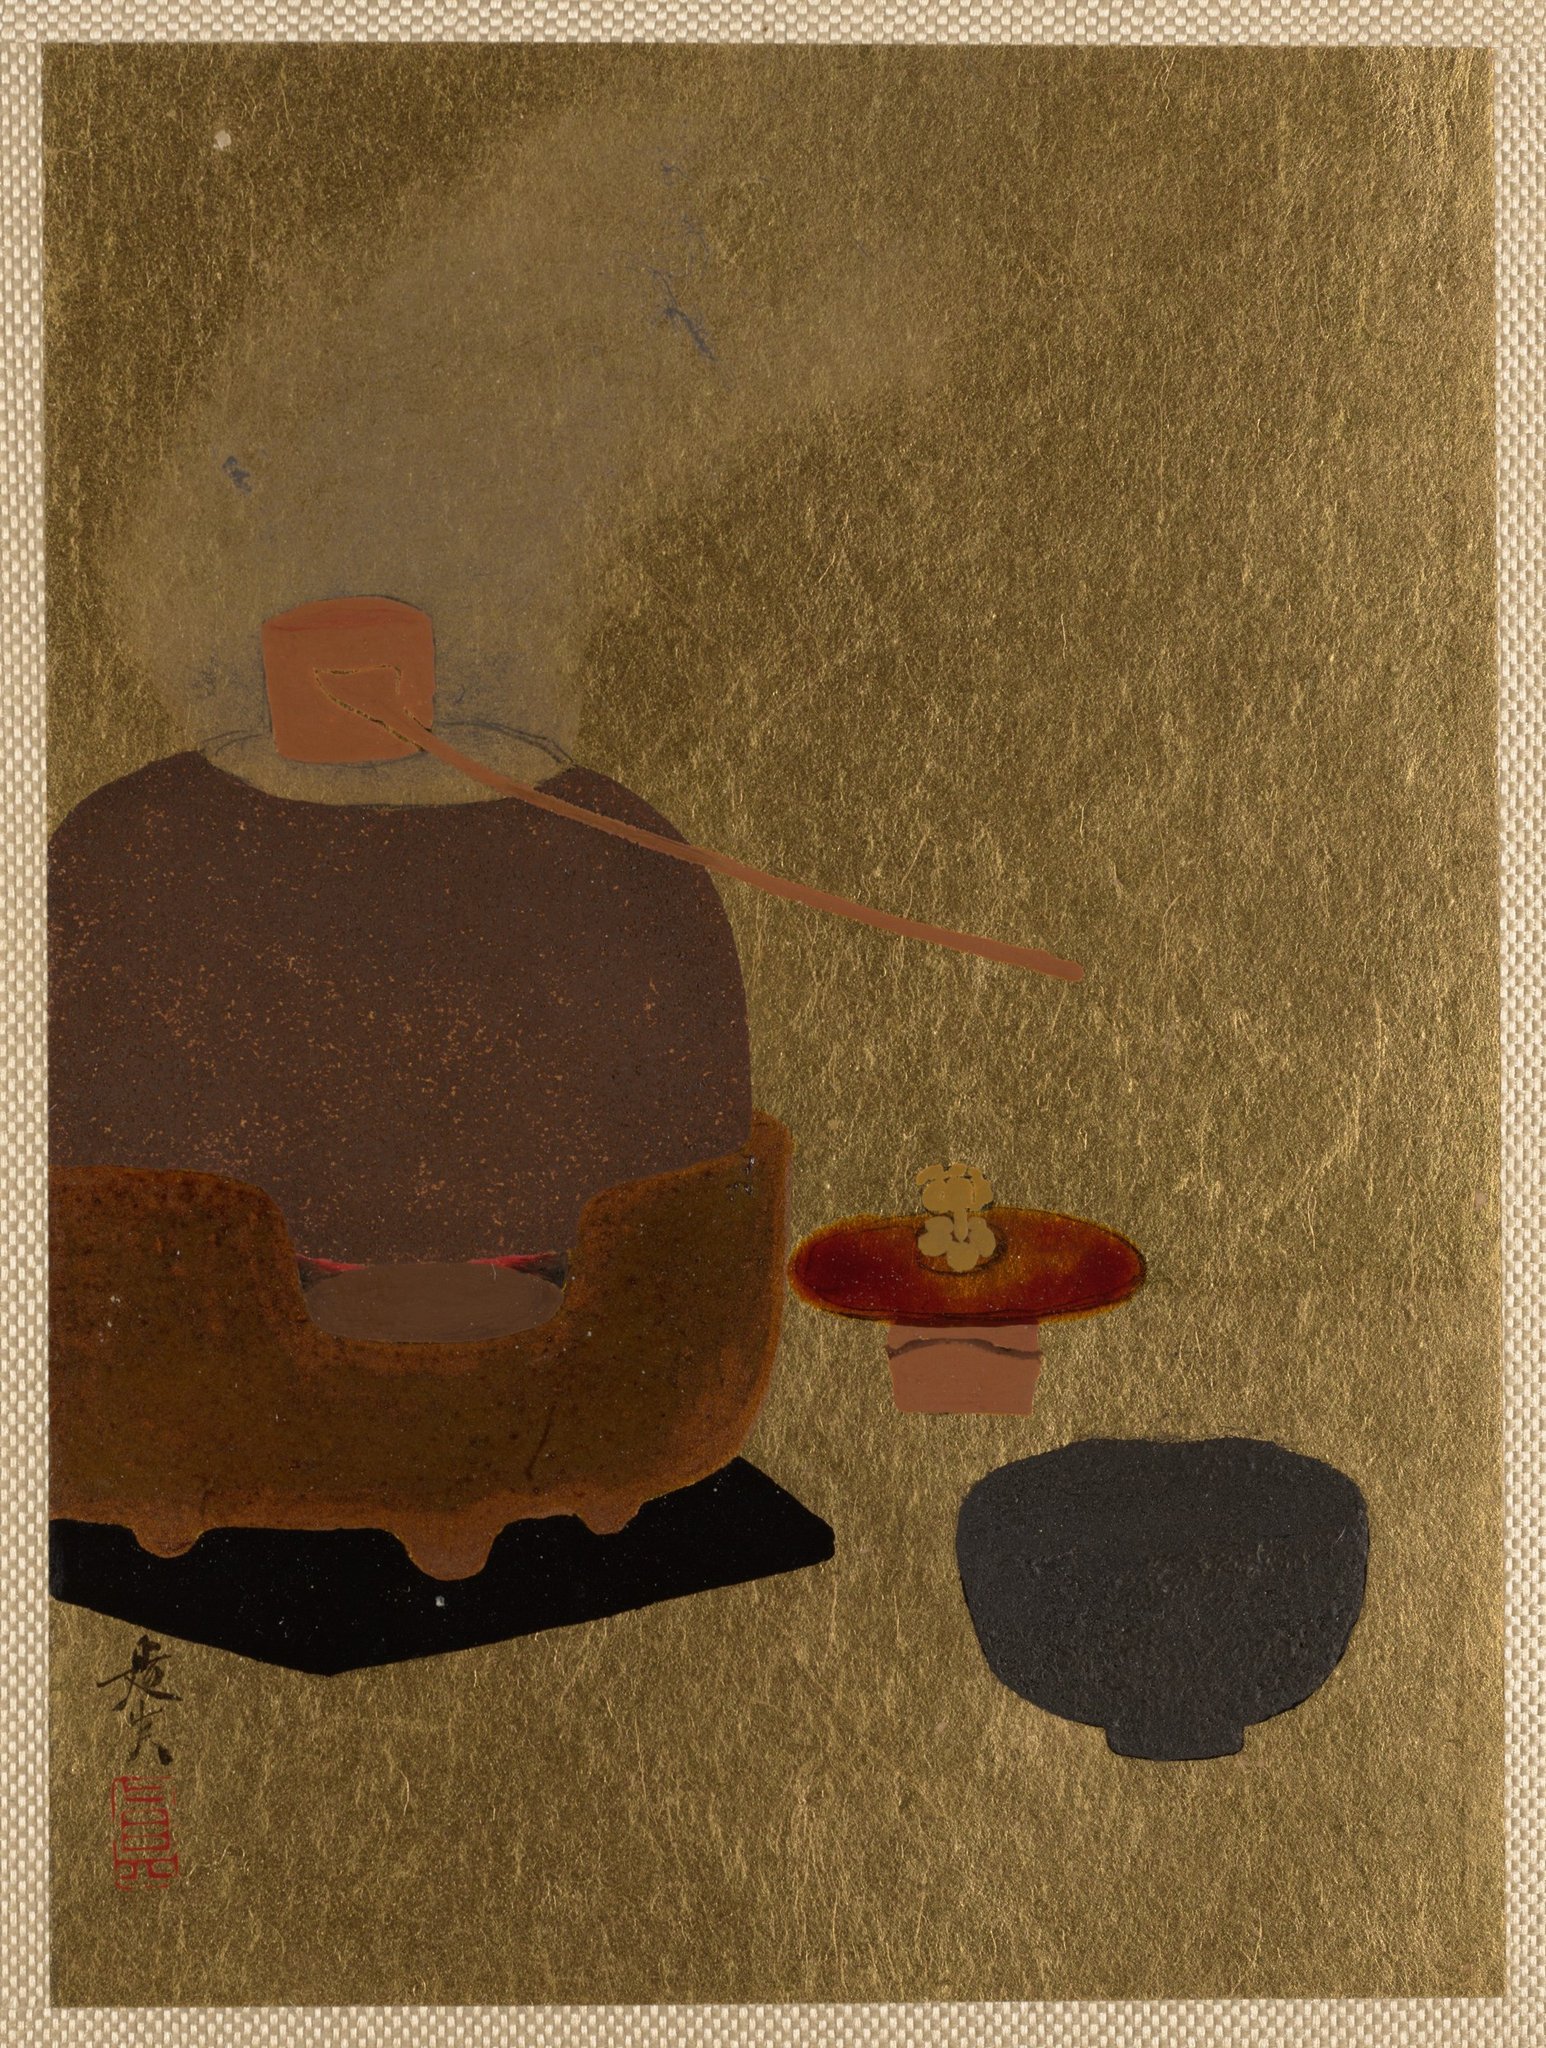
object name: album leaf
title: Tea Ceremony Apparatus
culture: japanese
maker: shibata zeshin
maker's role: artist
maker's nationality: japanese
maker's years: 1807-1891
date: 1807-1868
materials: gold, lacquer, paper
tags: tea ceremony